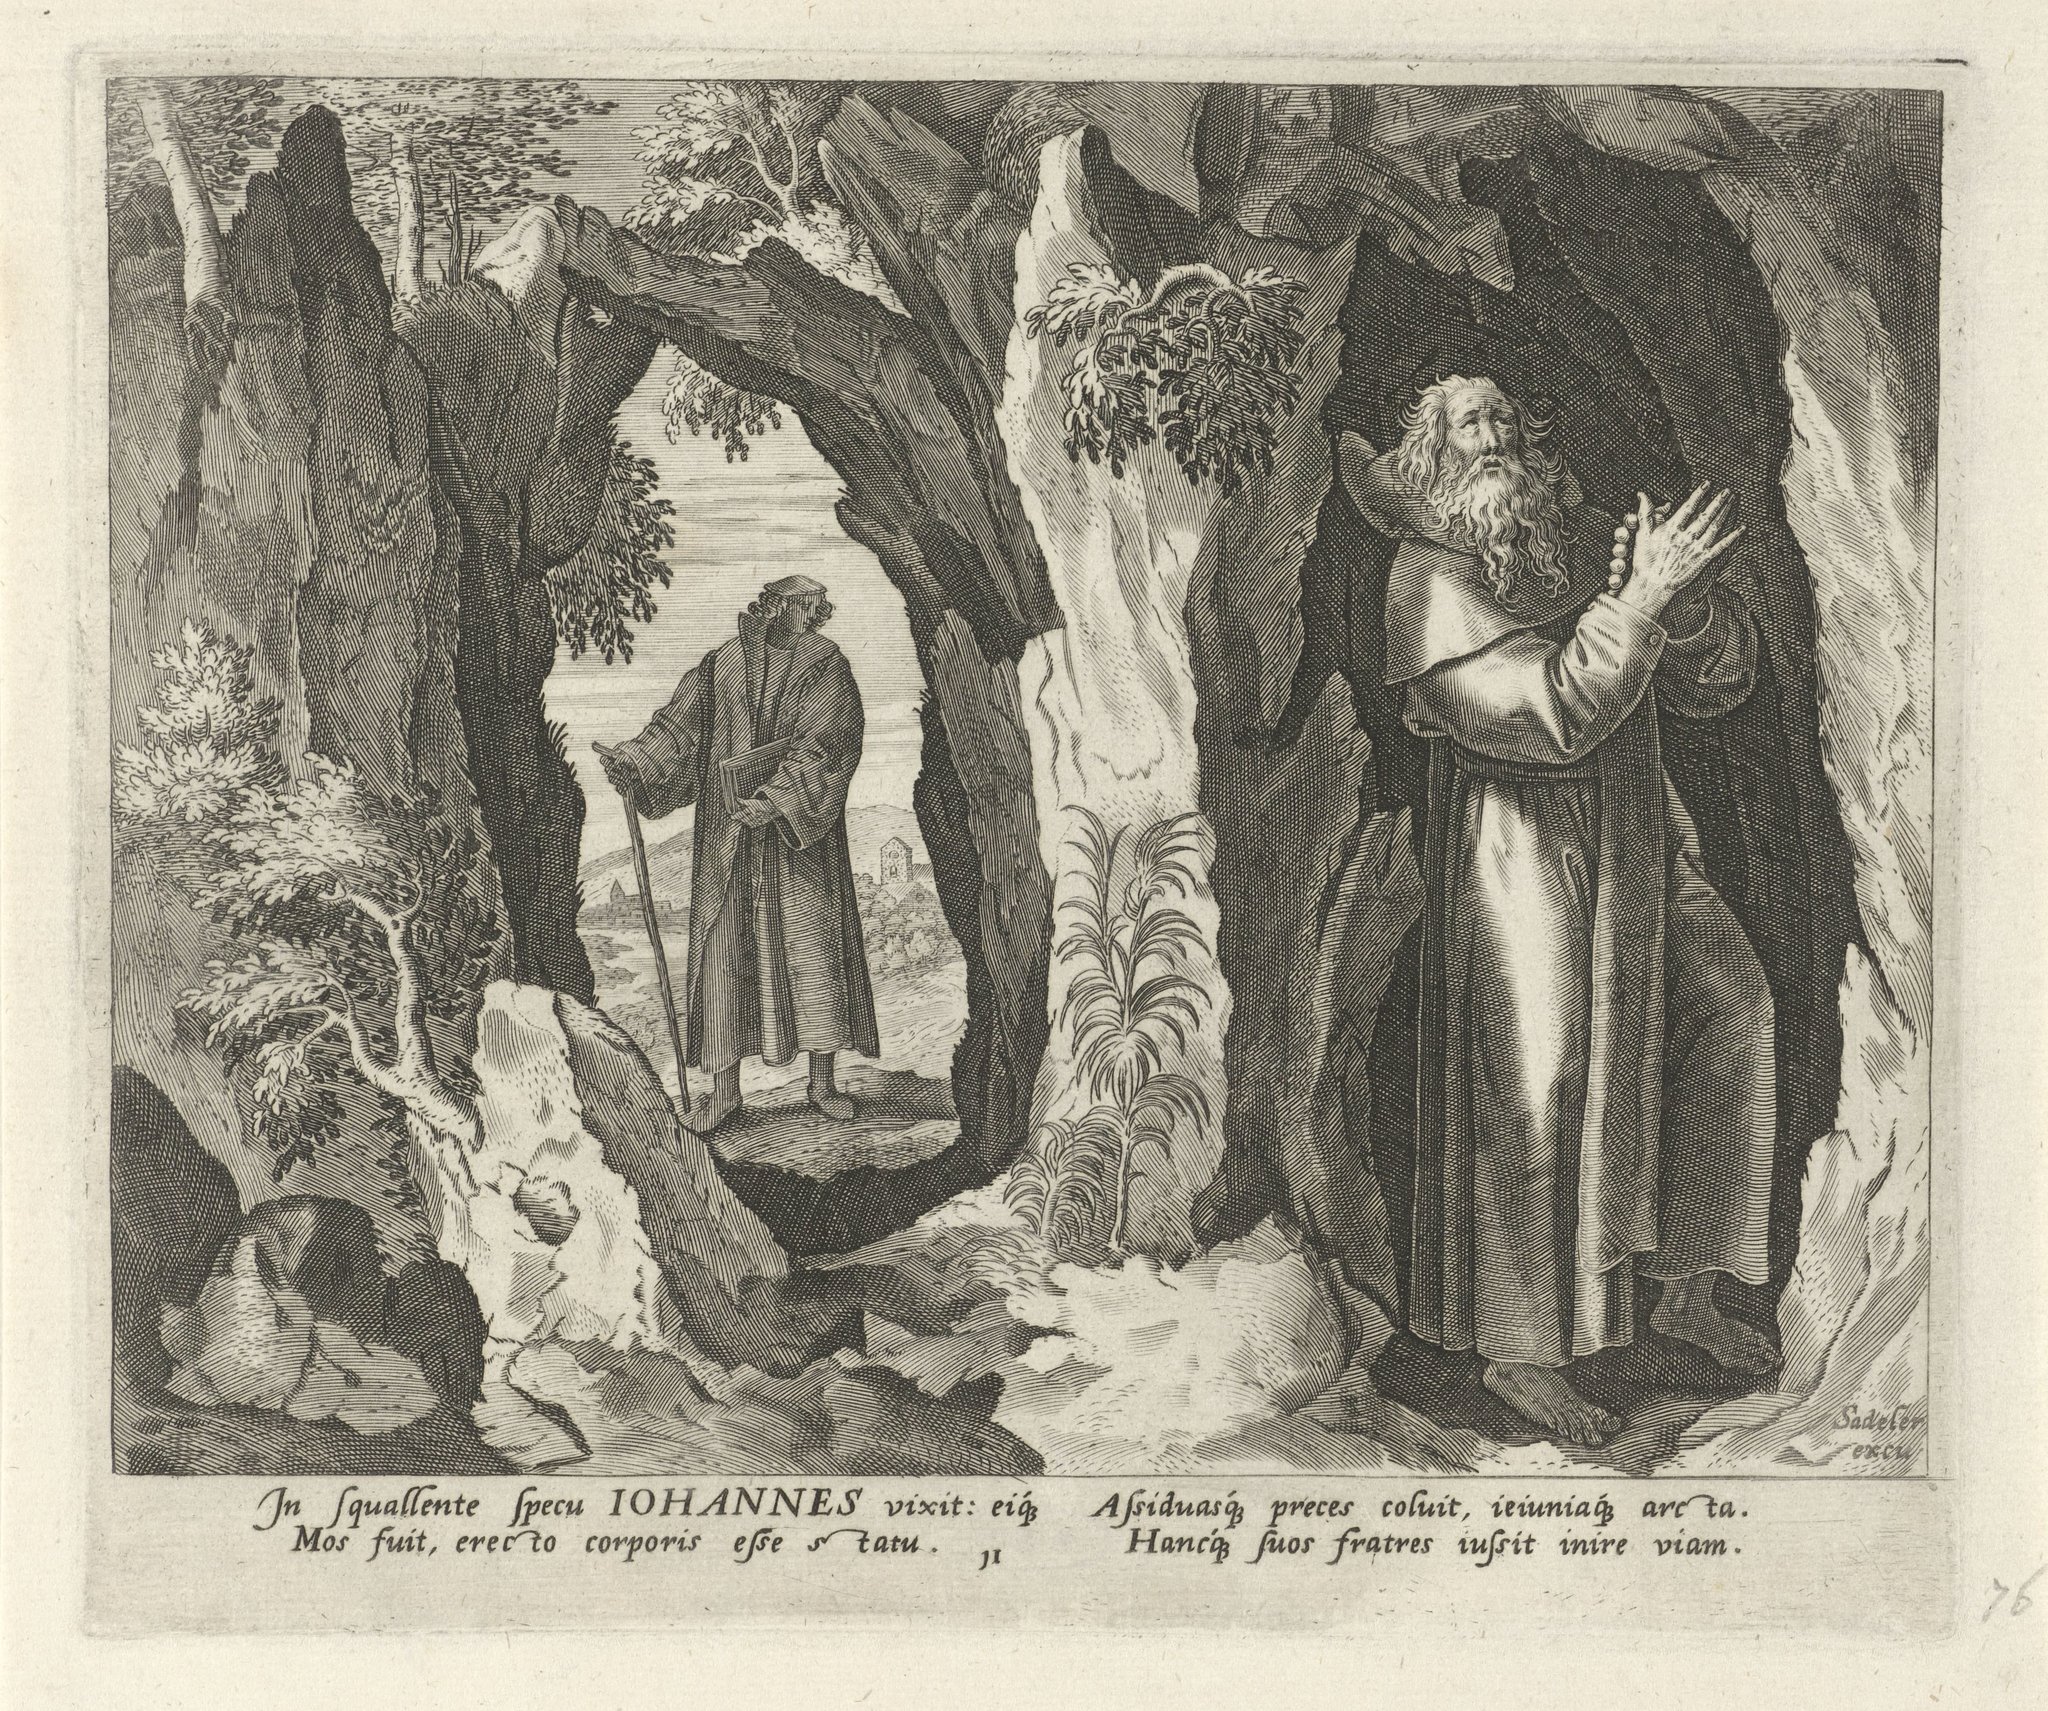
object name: print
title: Solitudo Sive Vitae Patrum Eremicolarum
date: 1583-1588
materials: paper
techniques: engraving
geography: antwerp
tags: wandering scholar, saints, anchorite, hermit, cave, grotto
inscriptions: collector's mark: Lugt 2228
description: Johannes de kluizenaar in een grot in de woestijn. Hij bidt de rozenkrans. Op de achtergrond staat een geleerde voor de ingang van de grot.